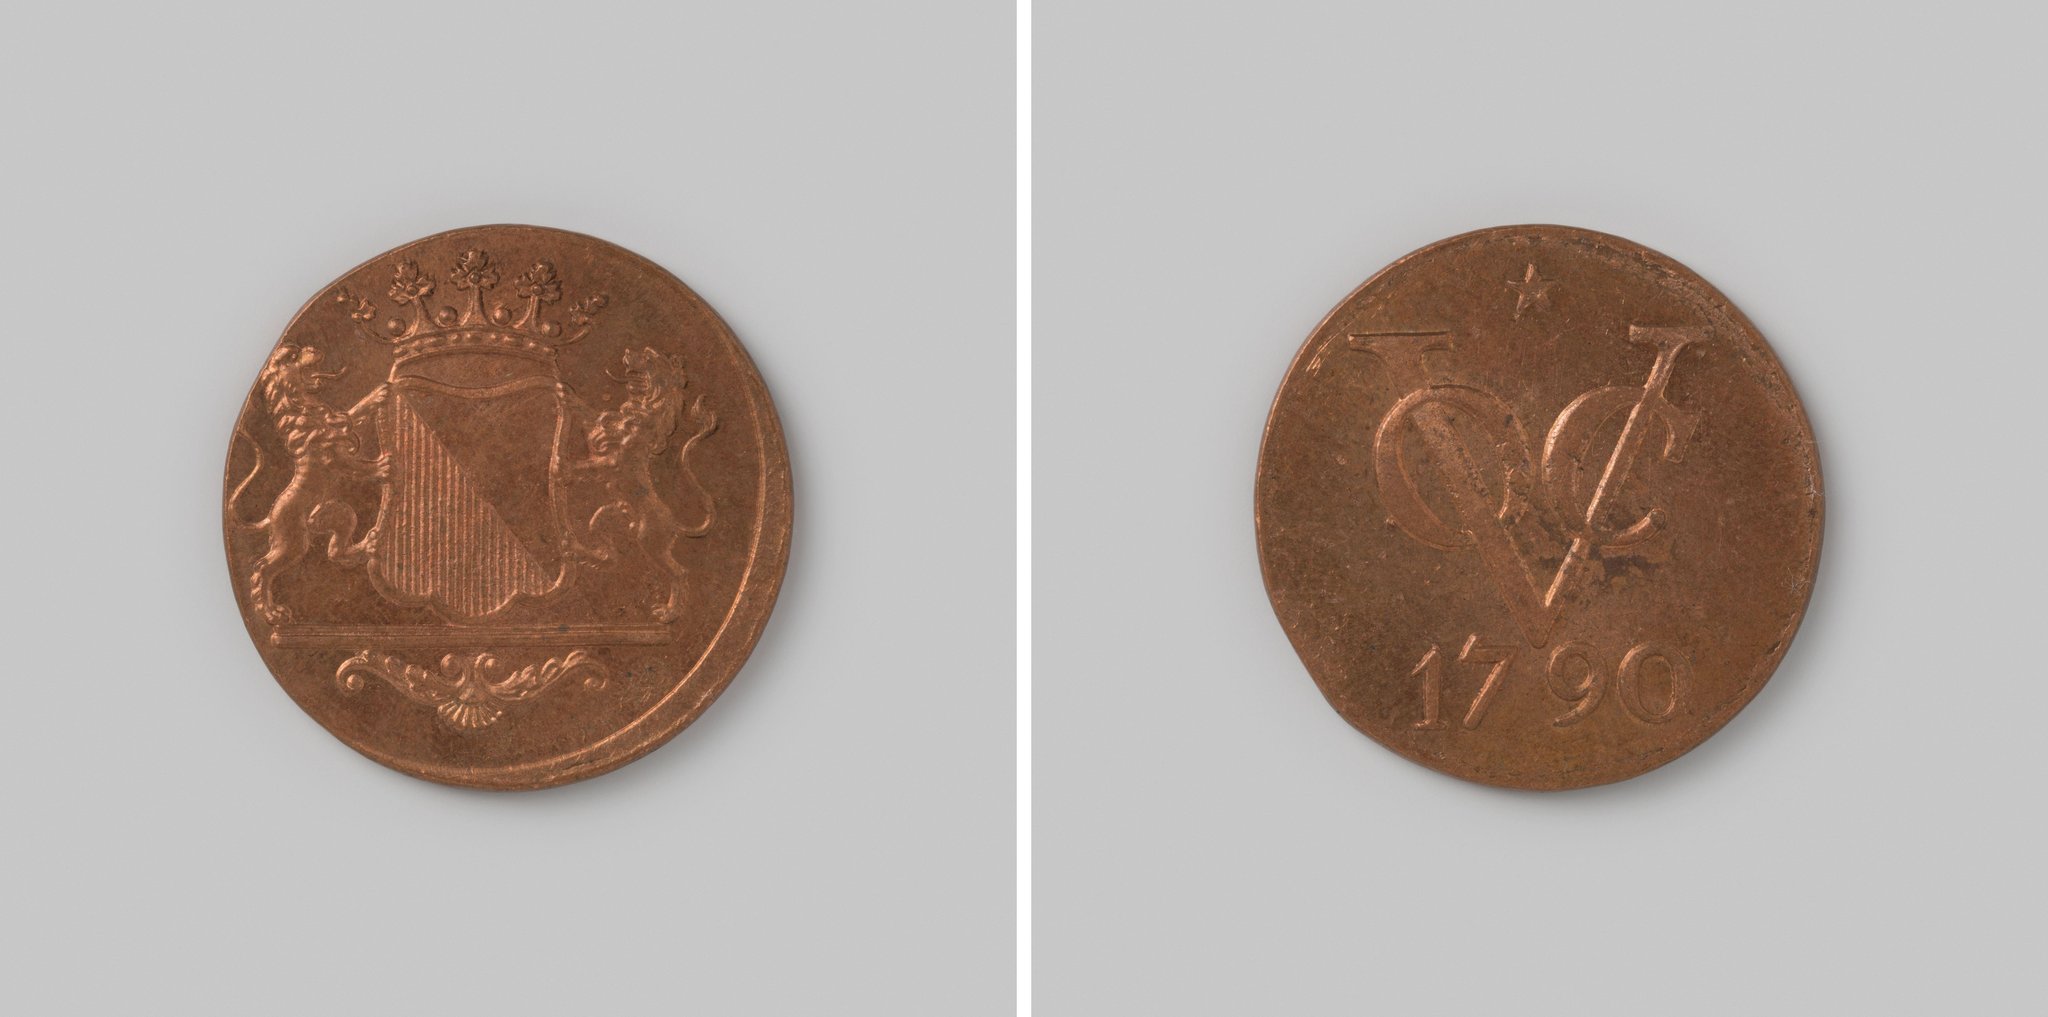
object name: coin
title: Dubbele duit op naam van de VOC en de stad Utrecht met jaartal 1790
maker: william ii of the netherlands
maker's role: koning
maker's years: 1792-1849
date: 1840-1843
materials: copper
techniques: striking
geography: surabaya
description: Koperen munt. Voorzijde: op balk, waaronder guirlande, staand, door twee leeuwen gehouden gekroond wapenschild van de stad Utrecht. Keerzijde: monogram van de VOC, waarboven muntteken ster en waaronder fictief jaartal 1790. Gladde rand.